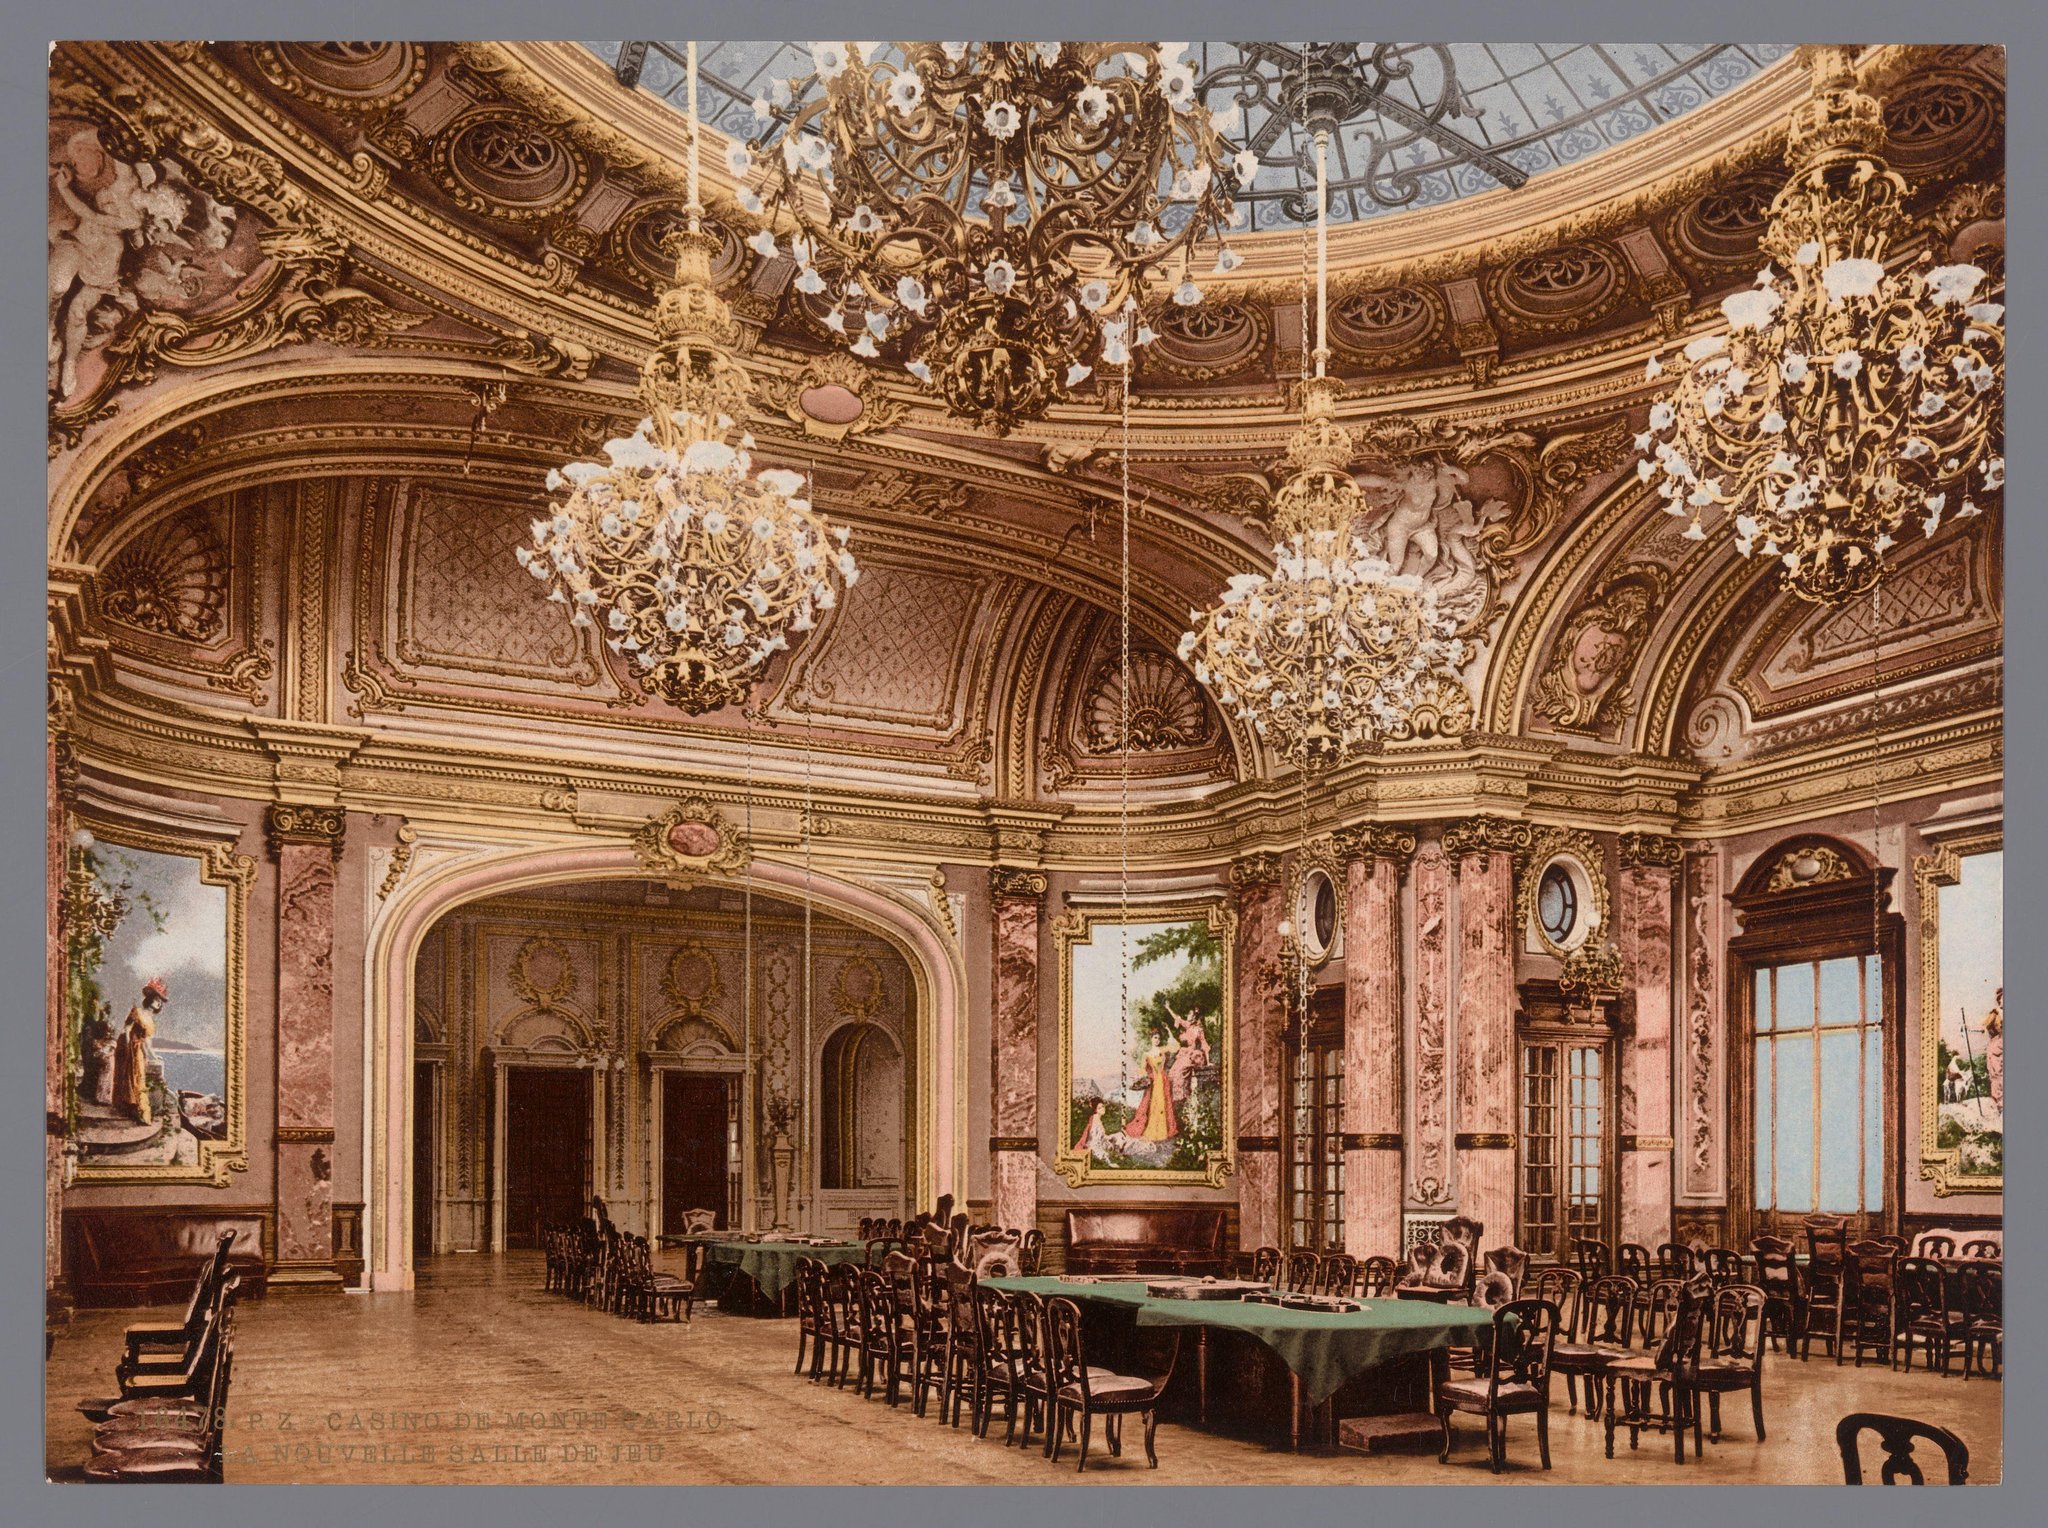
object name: photomechanical print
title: Interieur van het Monte Carlo Casino te Monaco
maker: Anonymous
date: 1889-1920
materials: paper, photographic process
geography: zurich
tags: casino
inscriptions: number: ‘16478.’